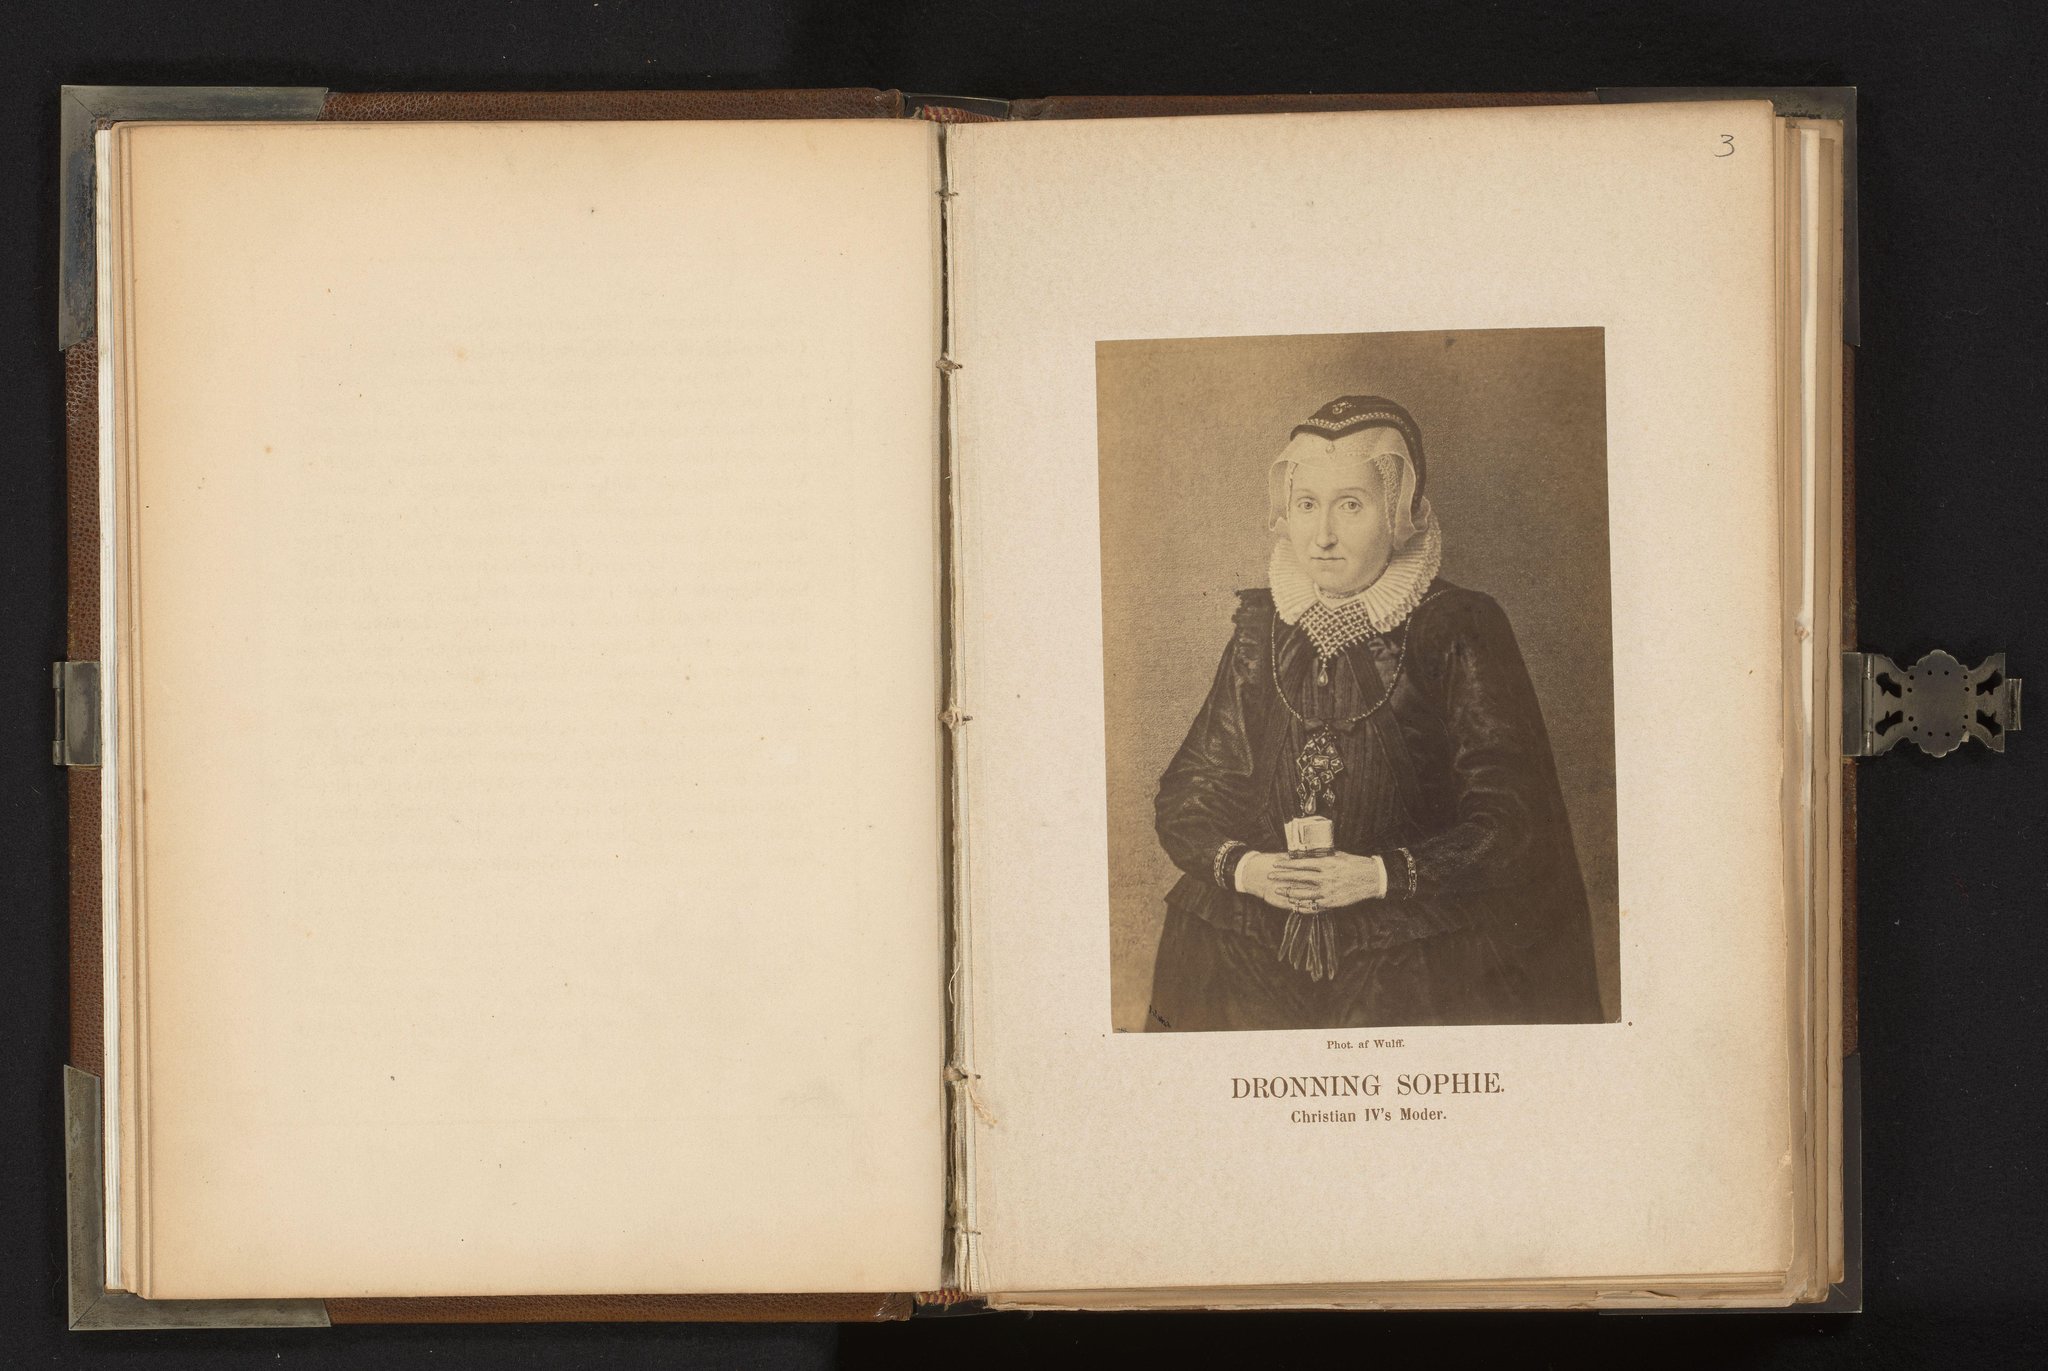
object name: reproduction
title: Fotoreproductie van een schilderij, voorstellende een portret van koningin Sophia van Mecklenburg-Güstrow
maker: julius wulff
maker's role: fotograaf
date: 1858-1863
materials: photographic support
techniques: albumen print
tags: ruler, sovereign - bb - female ruler